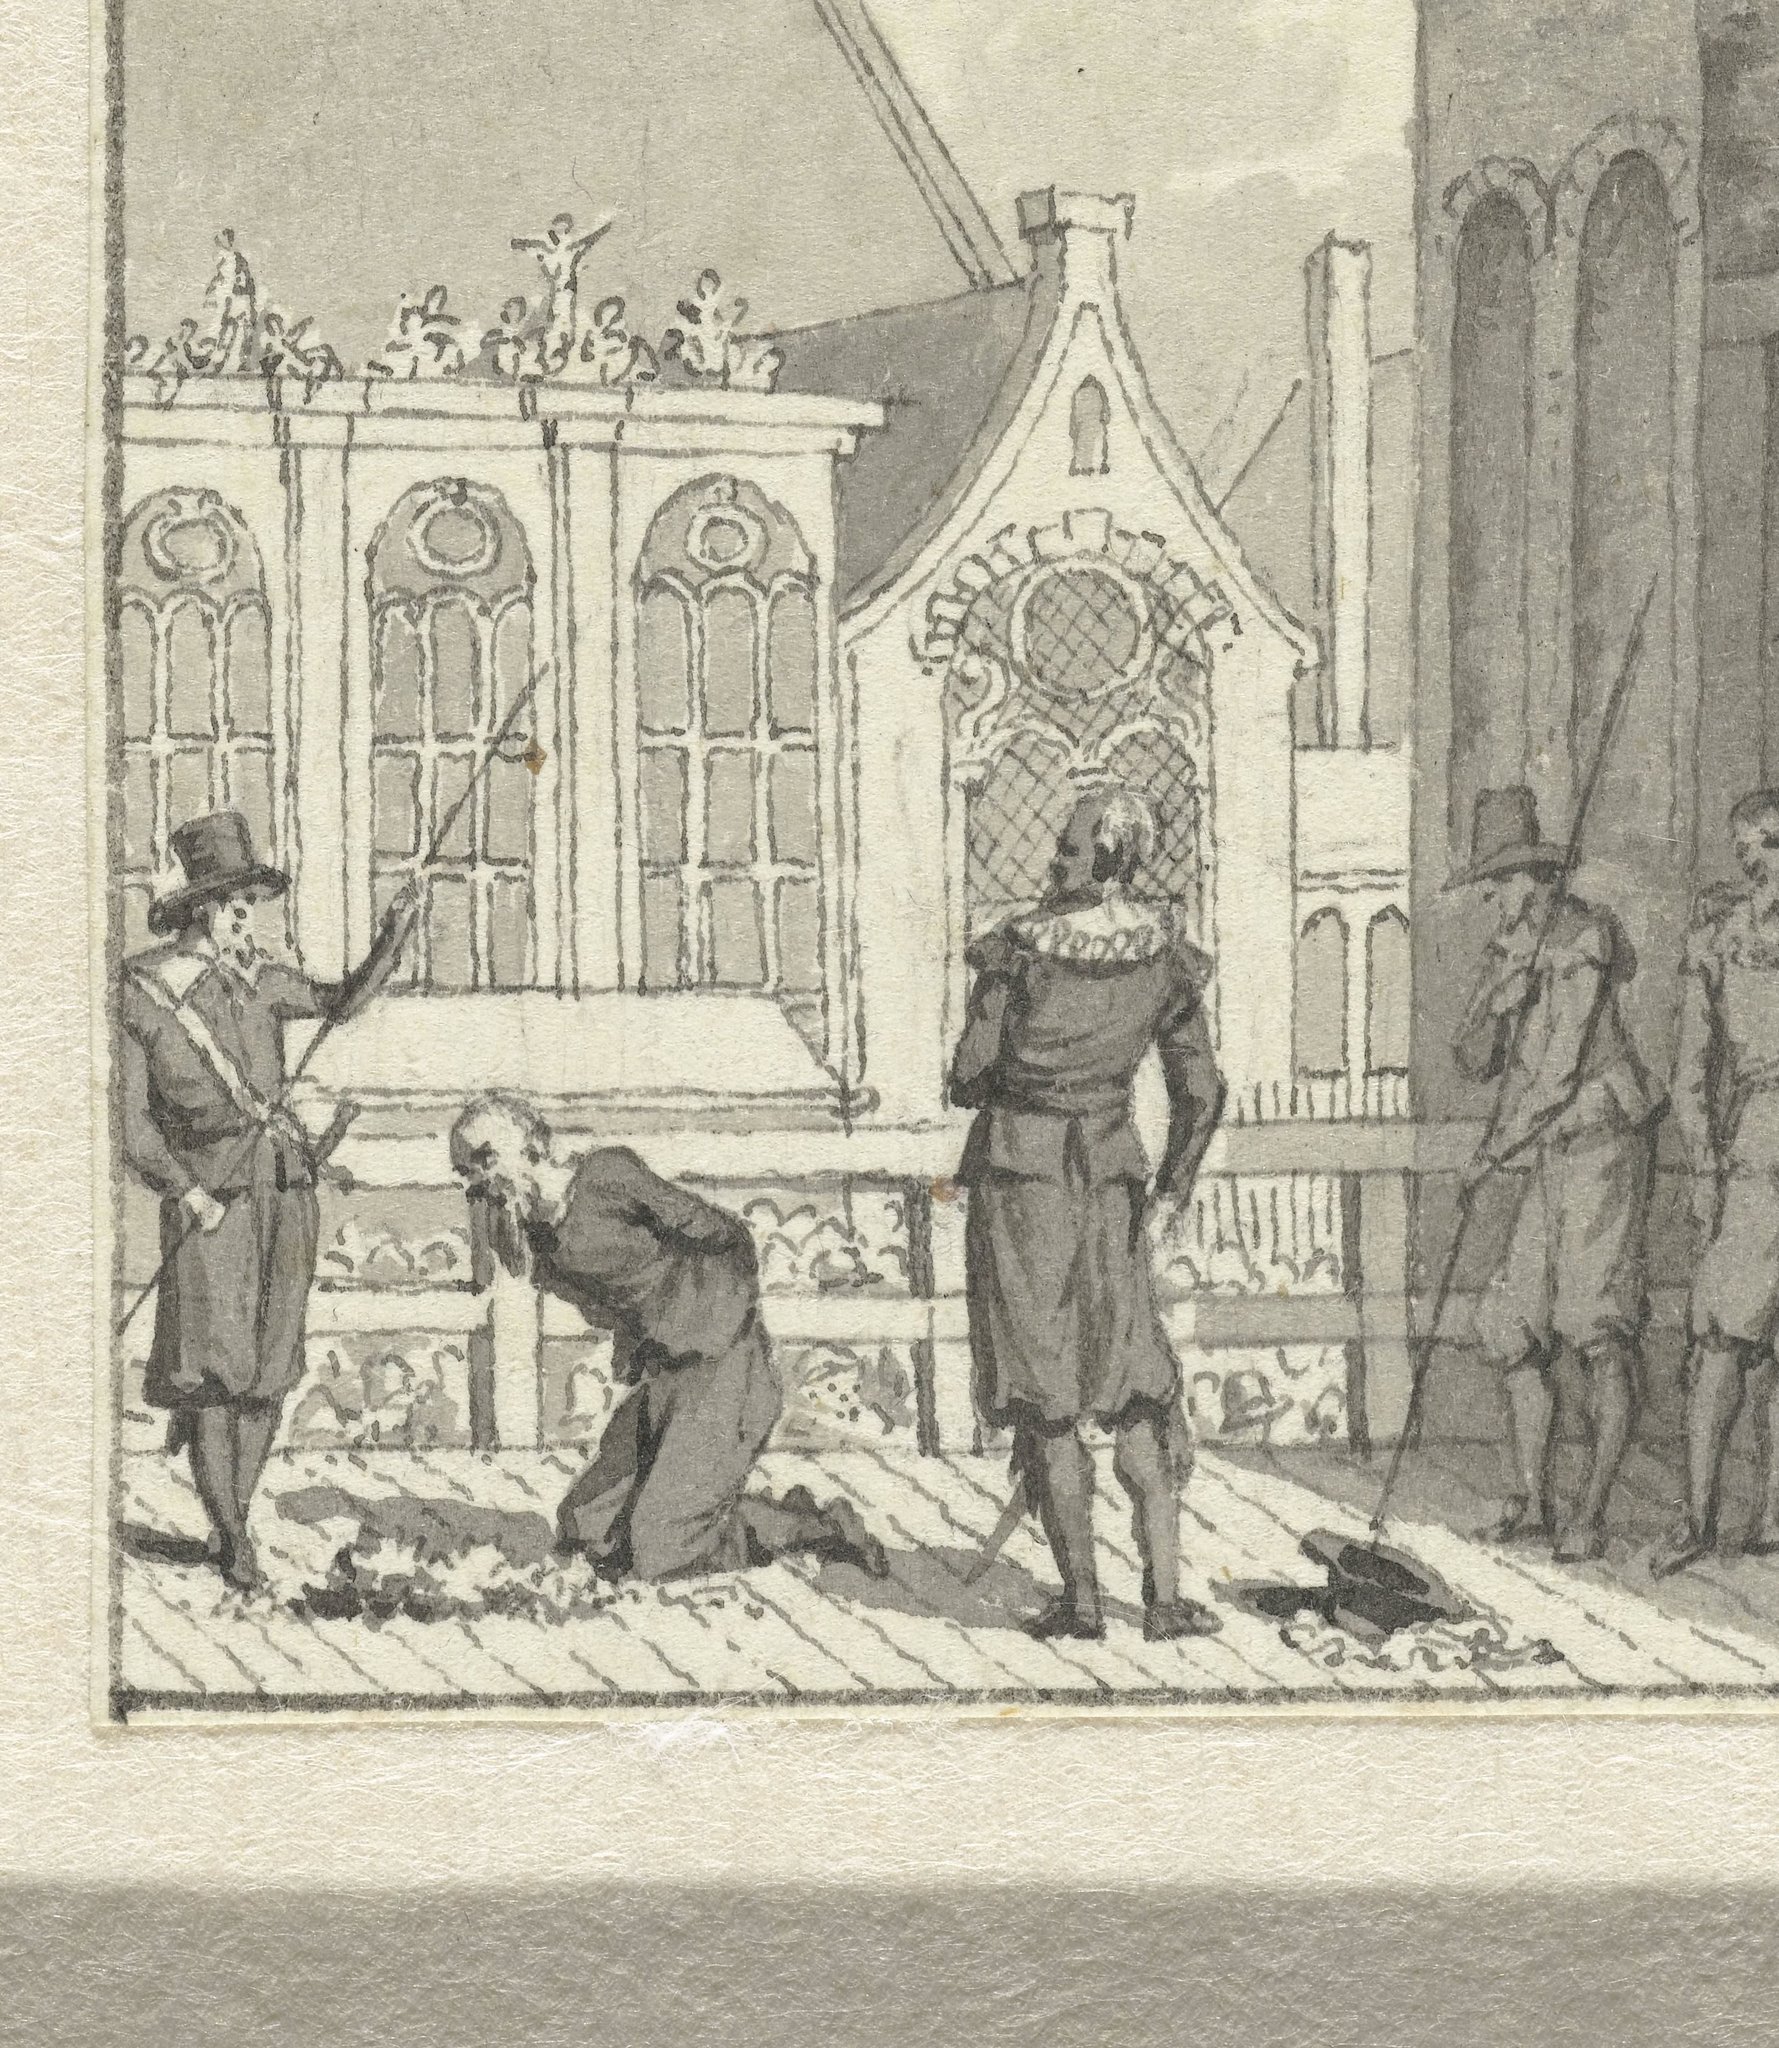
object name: design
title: In 't Jaar 1619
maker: Anonymous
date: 1789-1810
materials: ink, paper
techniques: brush, pen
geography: netherlands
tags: the hague, johan van oldenbarnevelt, on the scaffold or place of execution, violent death by beheading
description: Terechtstelling van Johan van Oldenbarnevelt, 13 mei 1619.